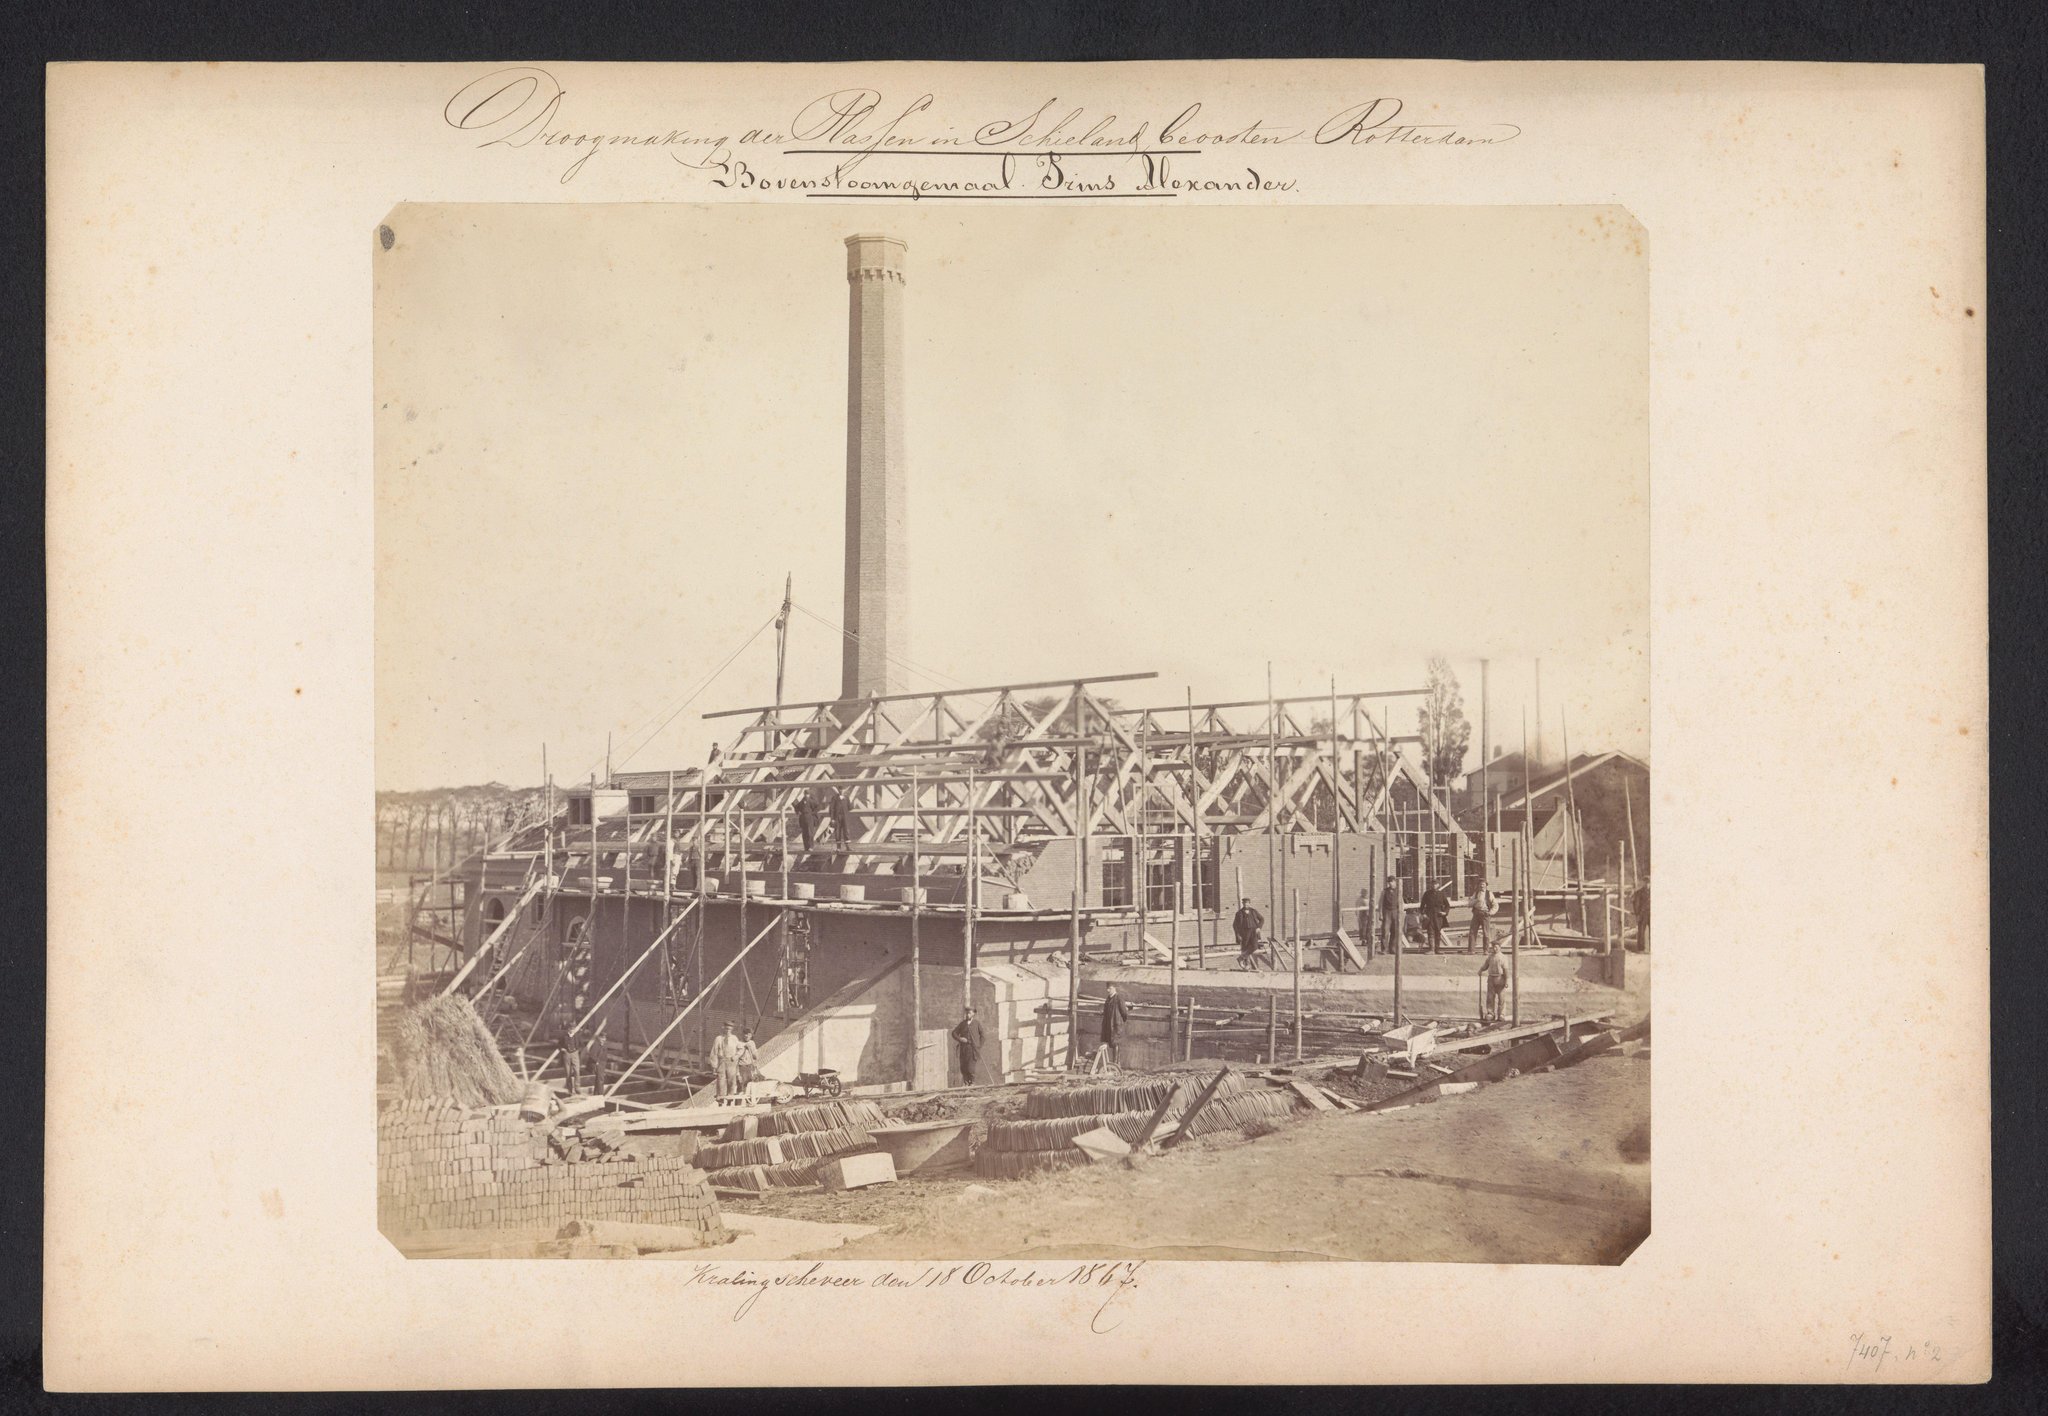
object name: photograph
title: Bovenstoomgemaal Prins Alexander / Kralingscheveer den 18 October 1867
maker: jacobus van gorkom (jr.)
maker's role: print maker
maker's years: 1827-1880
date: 1867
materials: cardboard, photographic support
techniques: albumen print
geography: rotterdam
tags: draining for land reclamation, pumping installation, pumping-engine (~ polder)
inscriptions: date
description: Stoomgemaal Prins Alexander aan de Kralingse Veer op 18 oktober 1867. Onderdeel van een serie van tien foto's van de droogmaking in 1867-1869 van de plassen in Schieland ten oosten van Rotterdam.